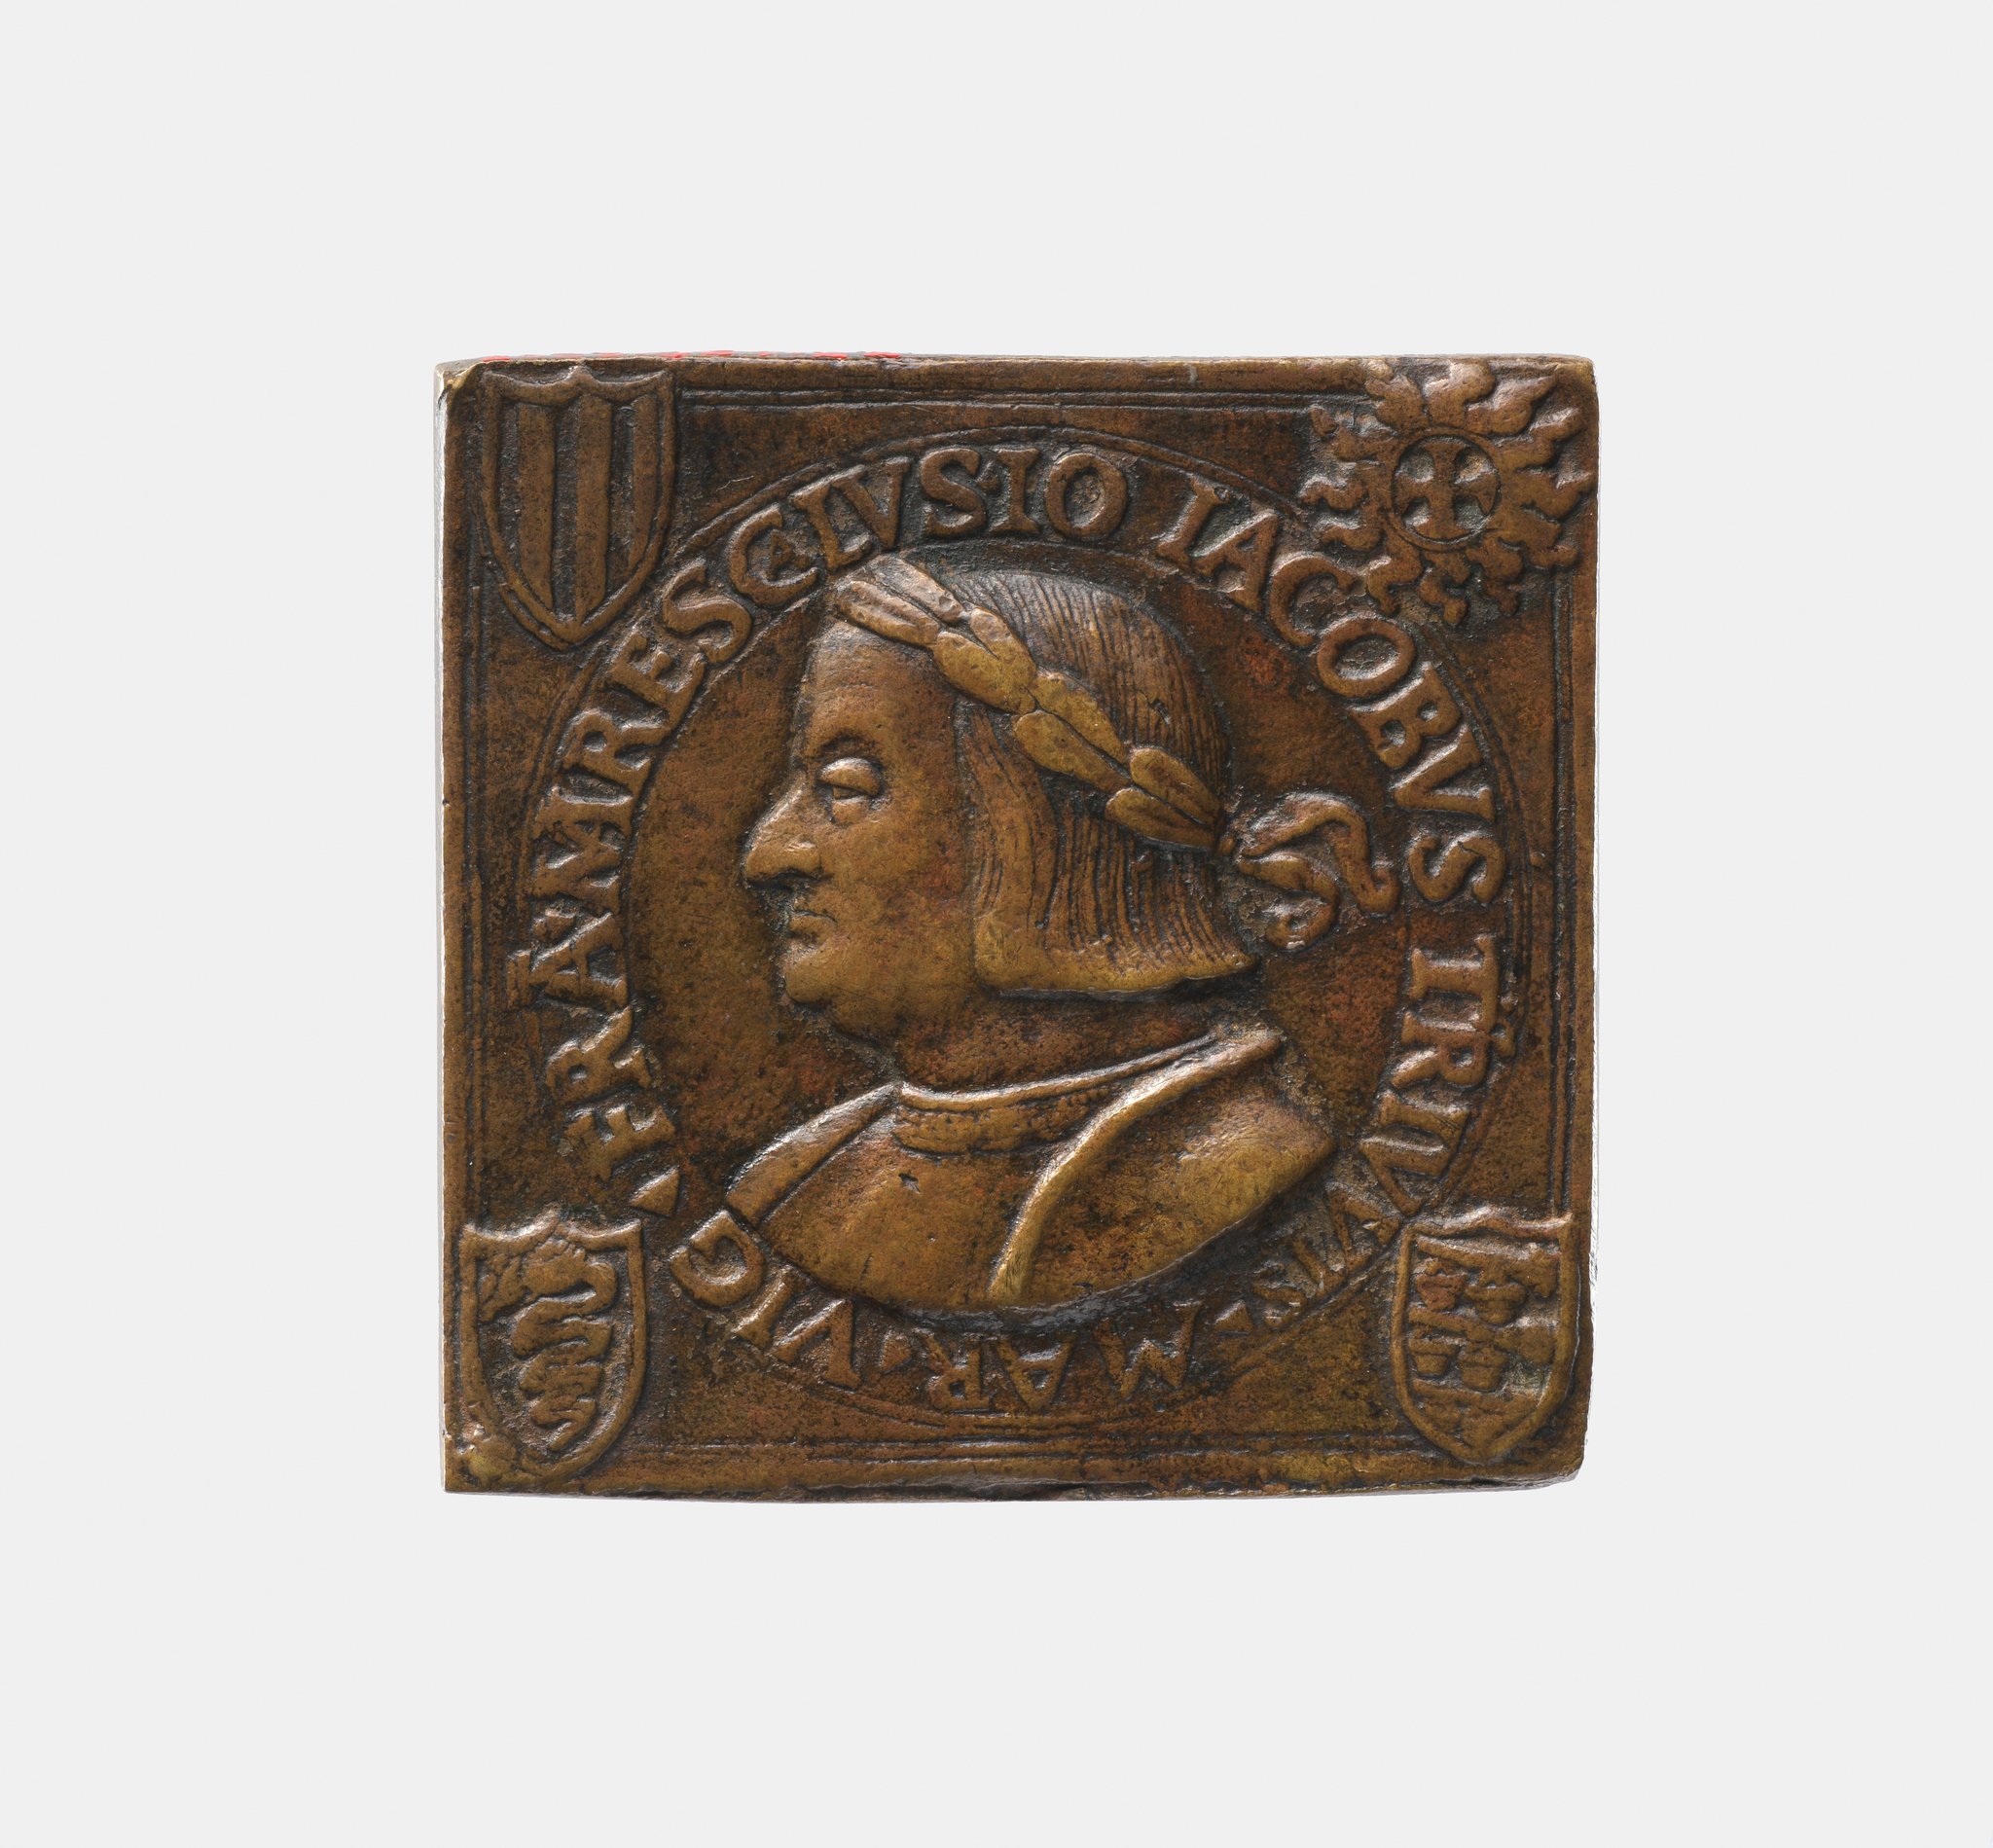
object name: medal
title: Giangiacomo Trivulzio 1441–1518, Marshal of France 1499, Marquis of Vigevano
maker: caradosso (cristoforo caradosso foppa)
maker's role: artist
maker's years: 1470-1527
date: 1475-1527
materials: bronze